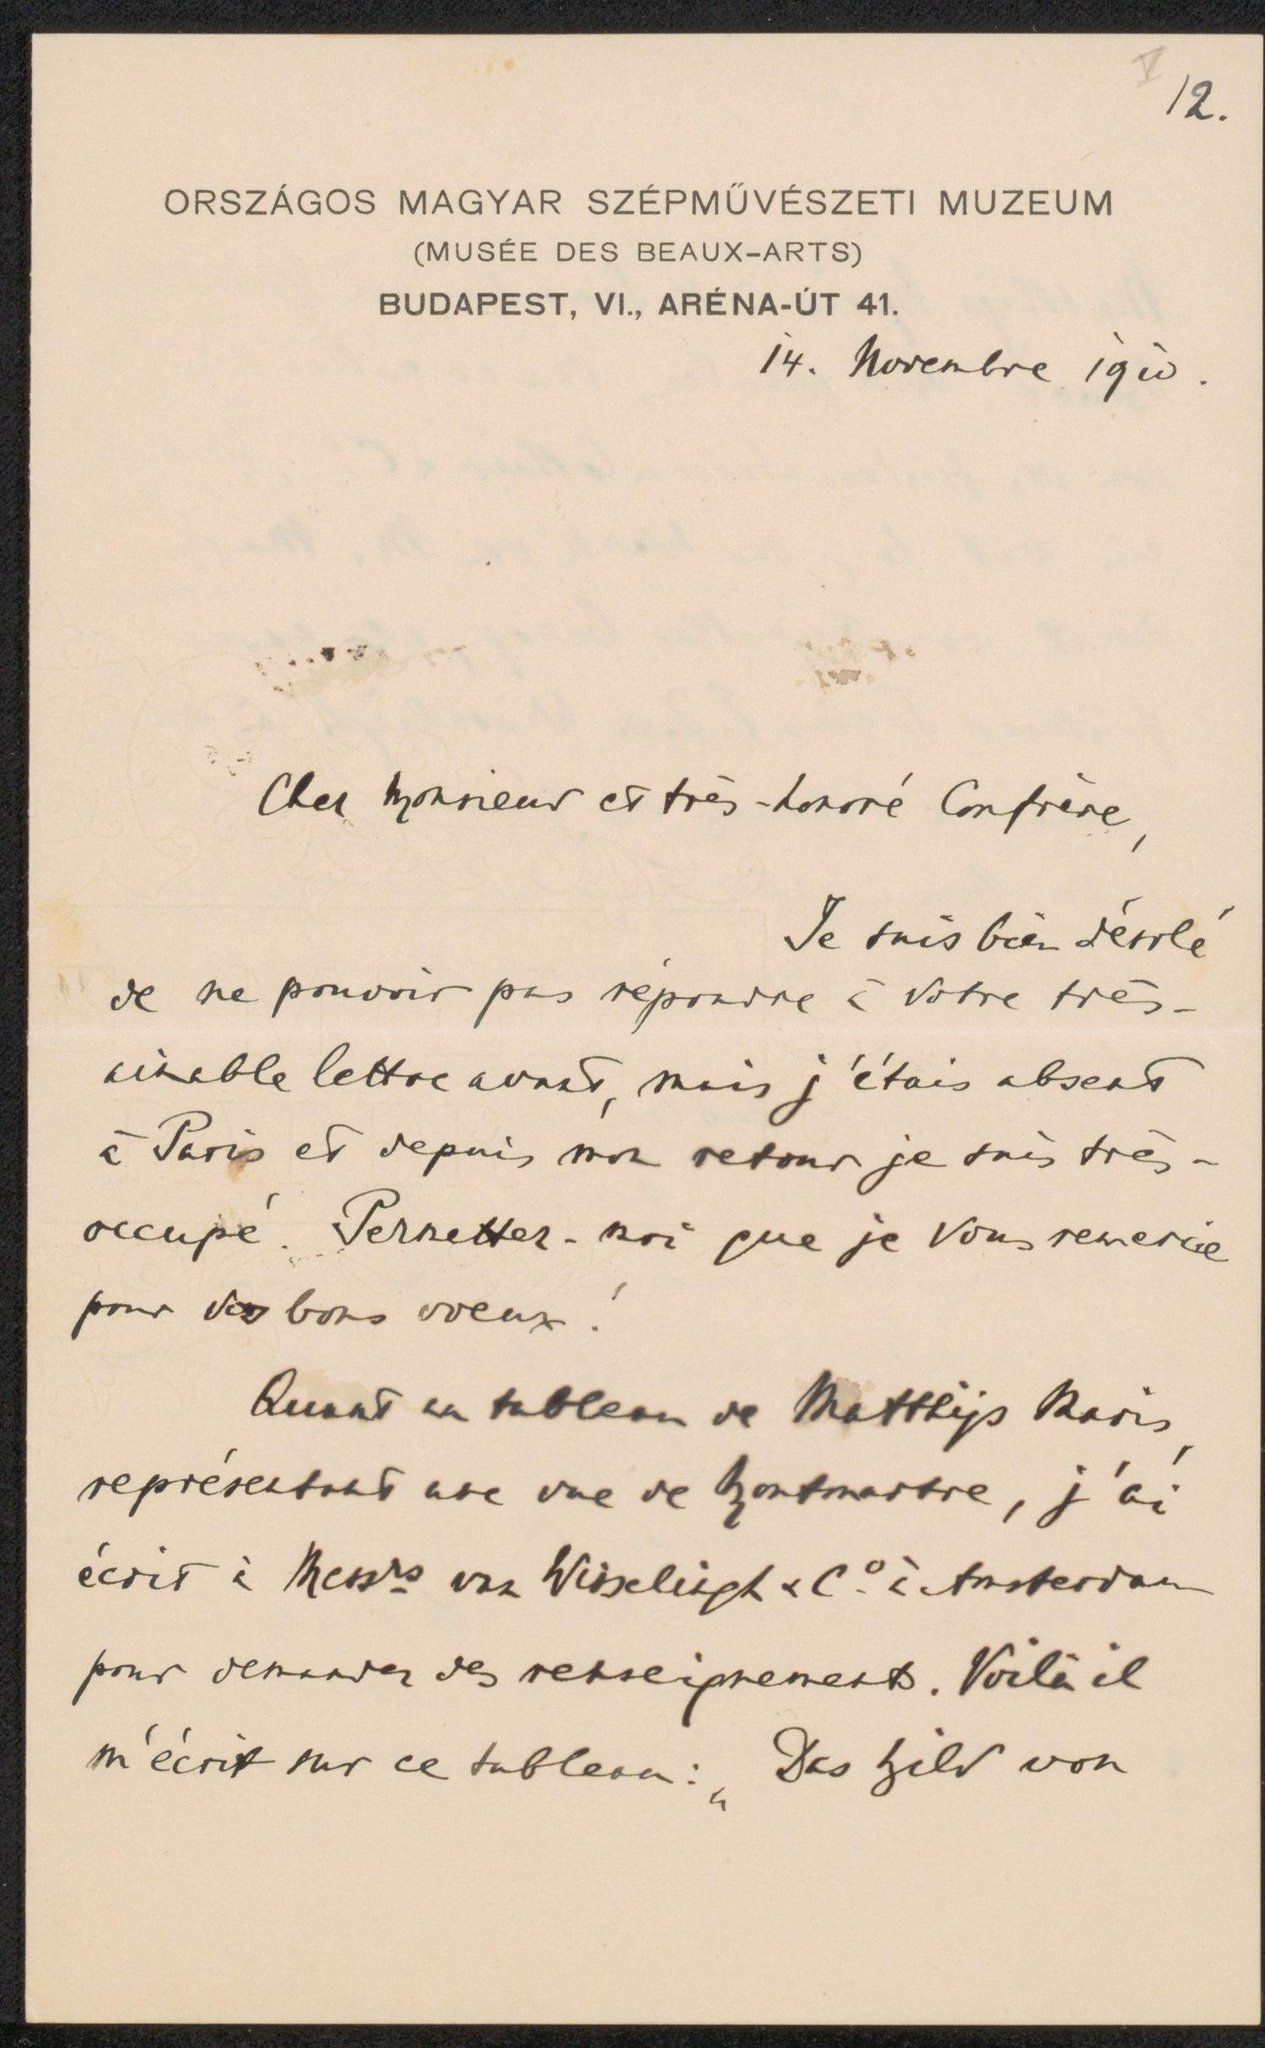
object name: letter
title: Brief aan Pieter Haverkorn van Rijsewijk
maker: gabriel de térey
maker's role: kunsthistoricus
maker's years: 1864-1927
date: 1910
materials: ink, paper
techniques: pen, printing, writing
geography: budapest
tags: painter, draughtsman, daniel cottier, the hague, print maker, matthijs maris, pieter haverkorn van rijsewijk, art trade, art shop, painting (including book-illumination, miniature-painting), art collecting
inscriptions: watermark